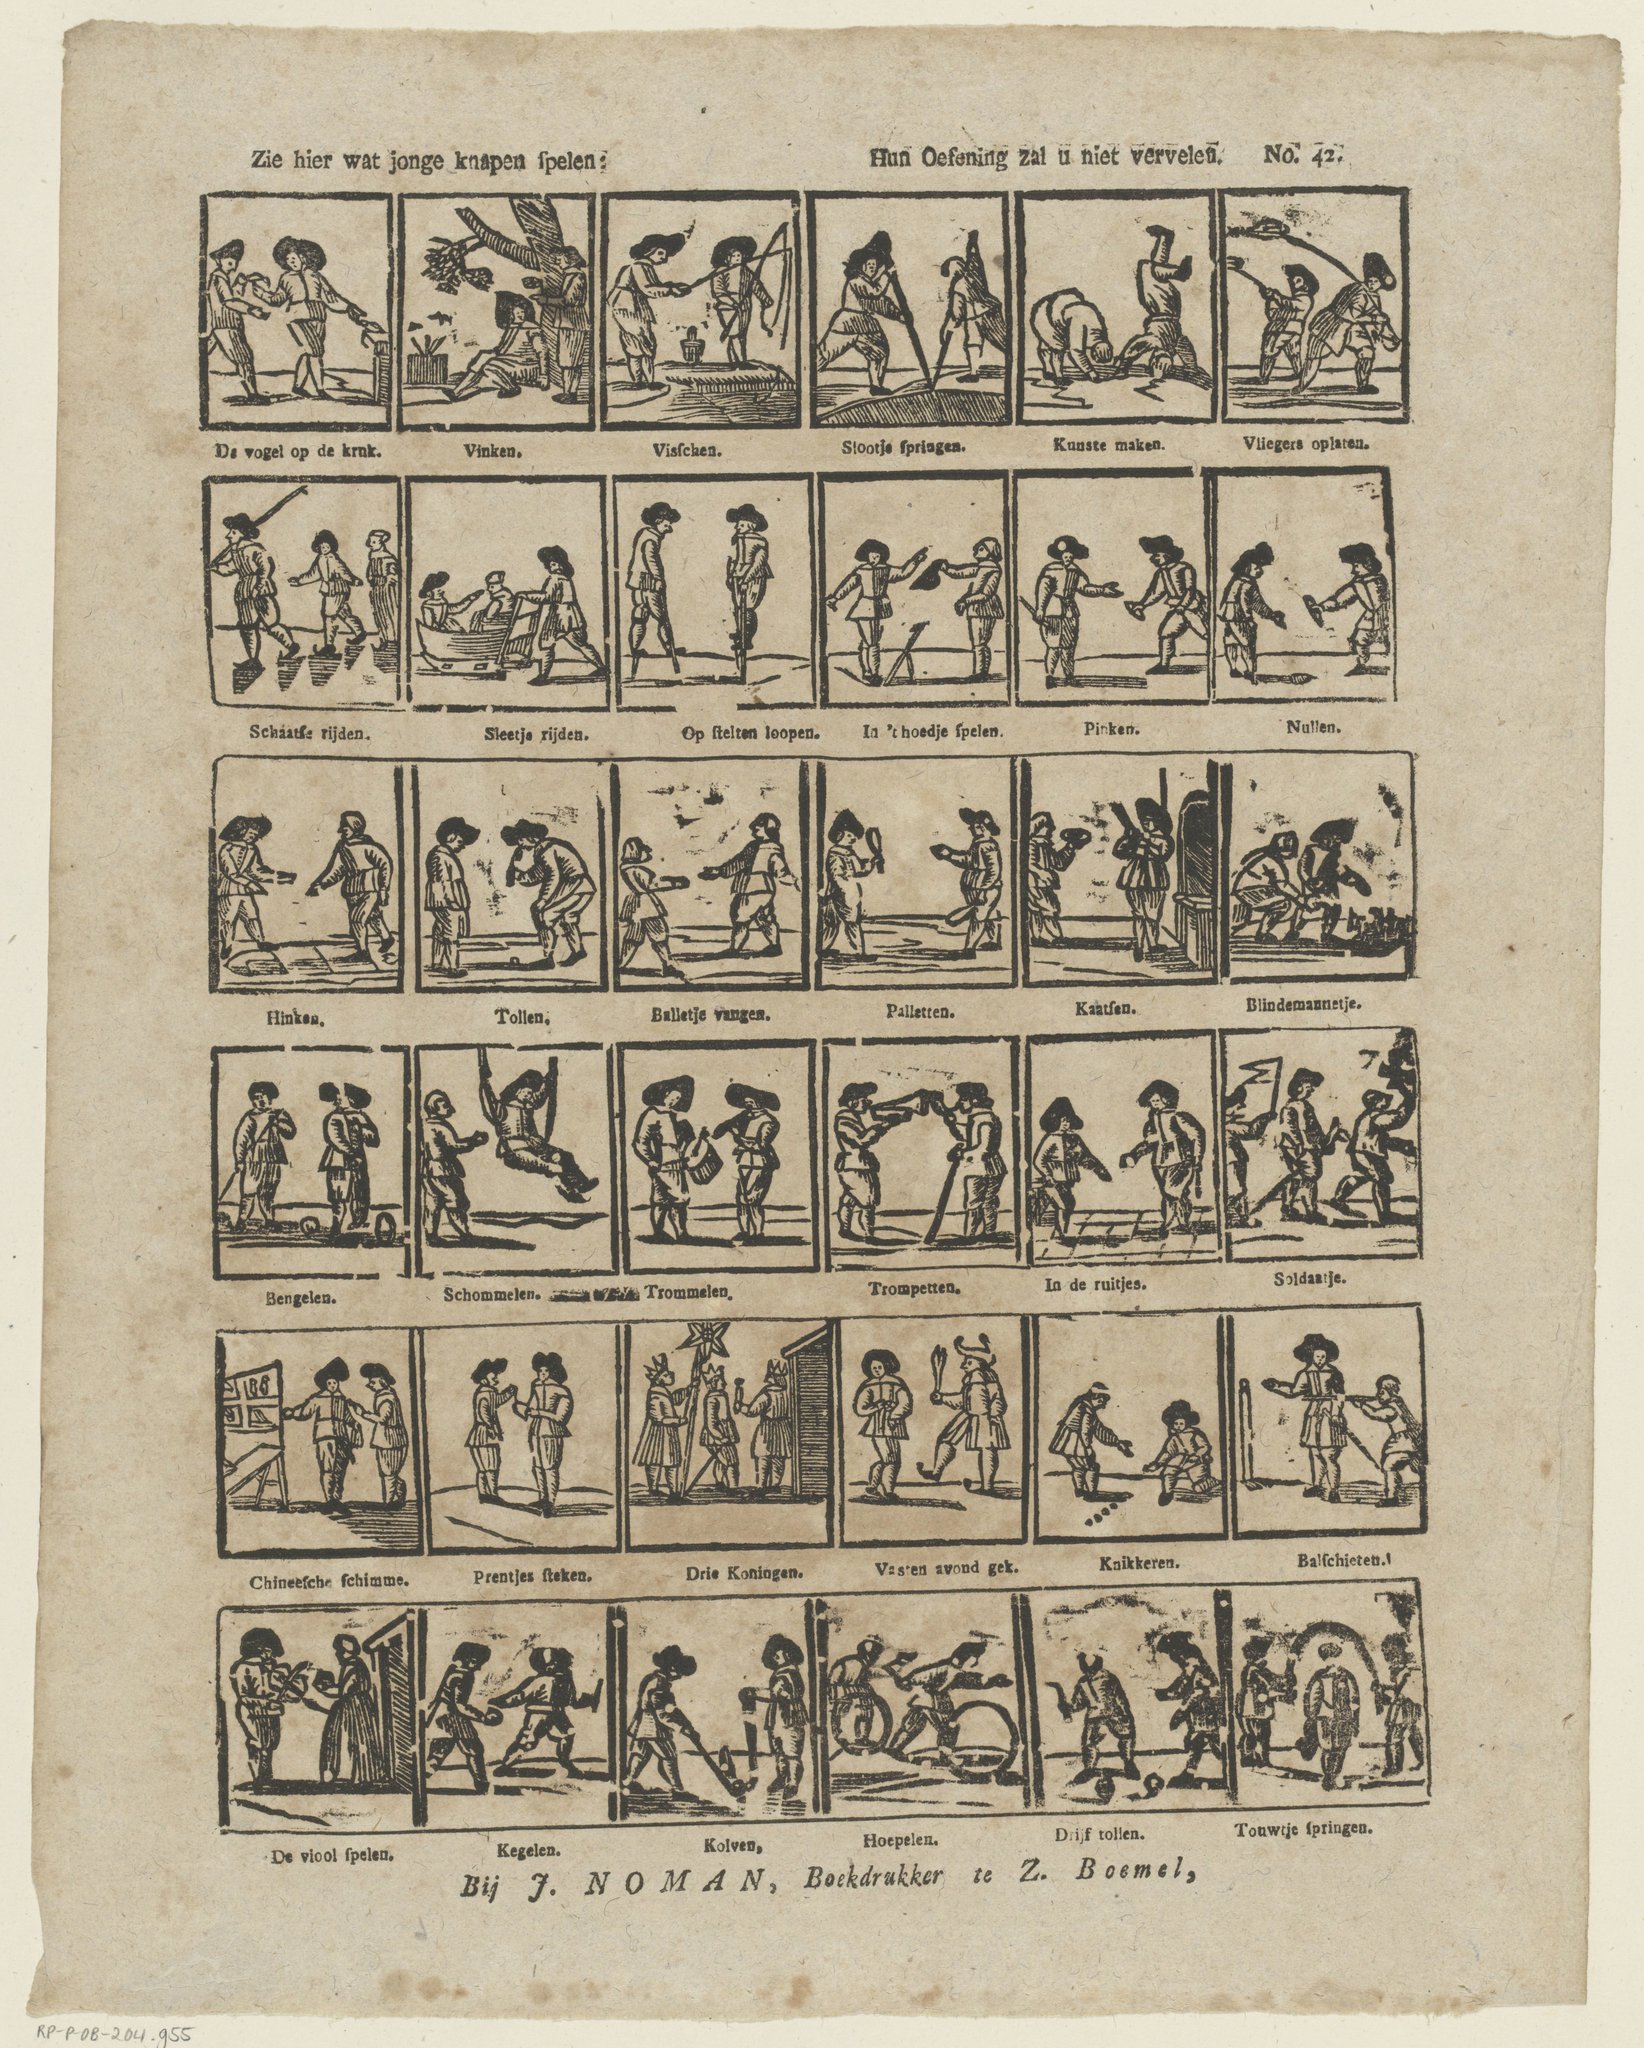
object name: print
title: Zie hier wat jonge knapen spelen: Hun oefening zal u niet vervelen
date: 1806-1830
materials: paper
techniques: letterpress printing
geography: netherlands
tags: children's games and plays, skates (winter sports), fishing (sports), games using special objects (marbles, top, hoop, etc.), jumping-rope games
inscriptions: collector's mark: Lugt 2760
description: Blad met 36 voorstellingen van kinderspelen en bezigheden, zoals vissen, schaatsen, hinkelen en knikkeren. Onder elke afbeelding een onderschrift. Genummerd rechtsboven: No. 42.